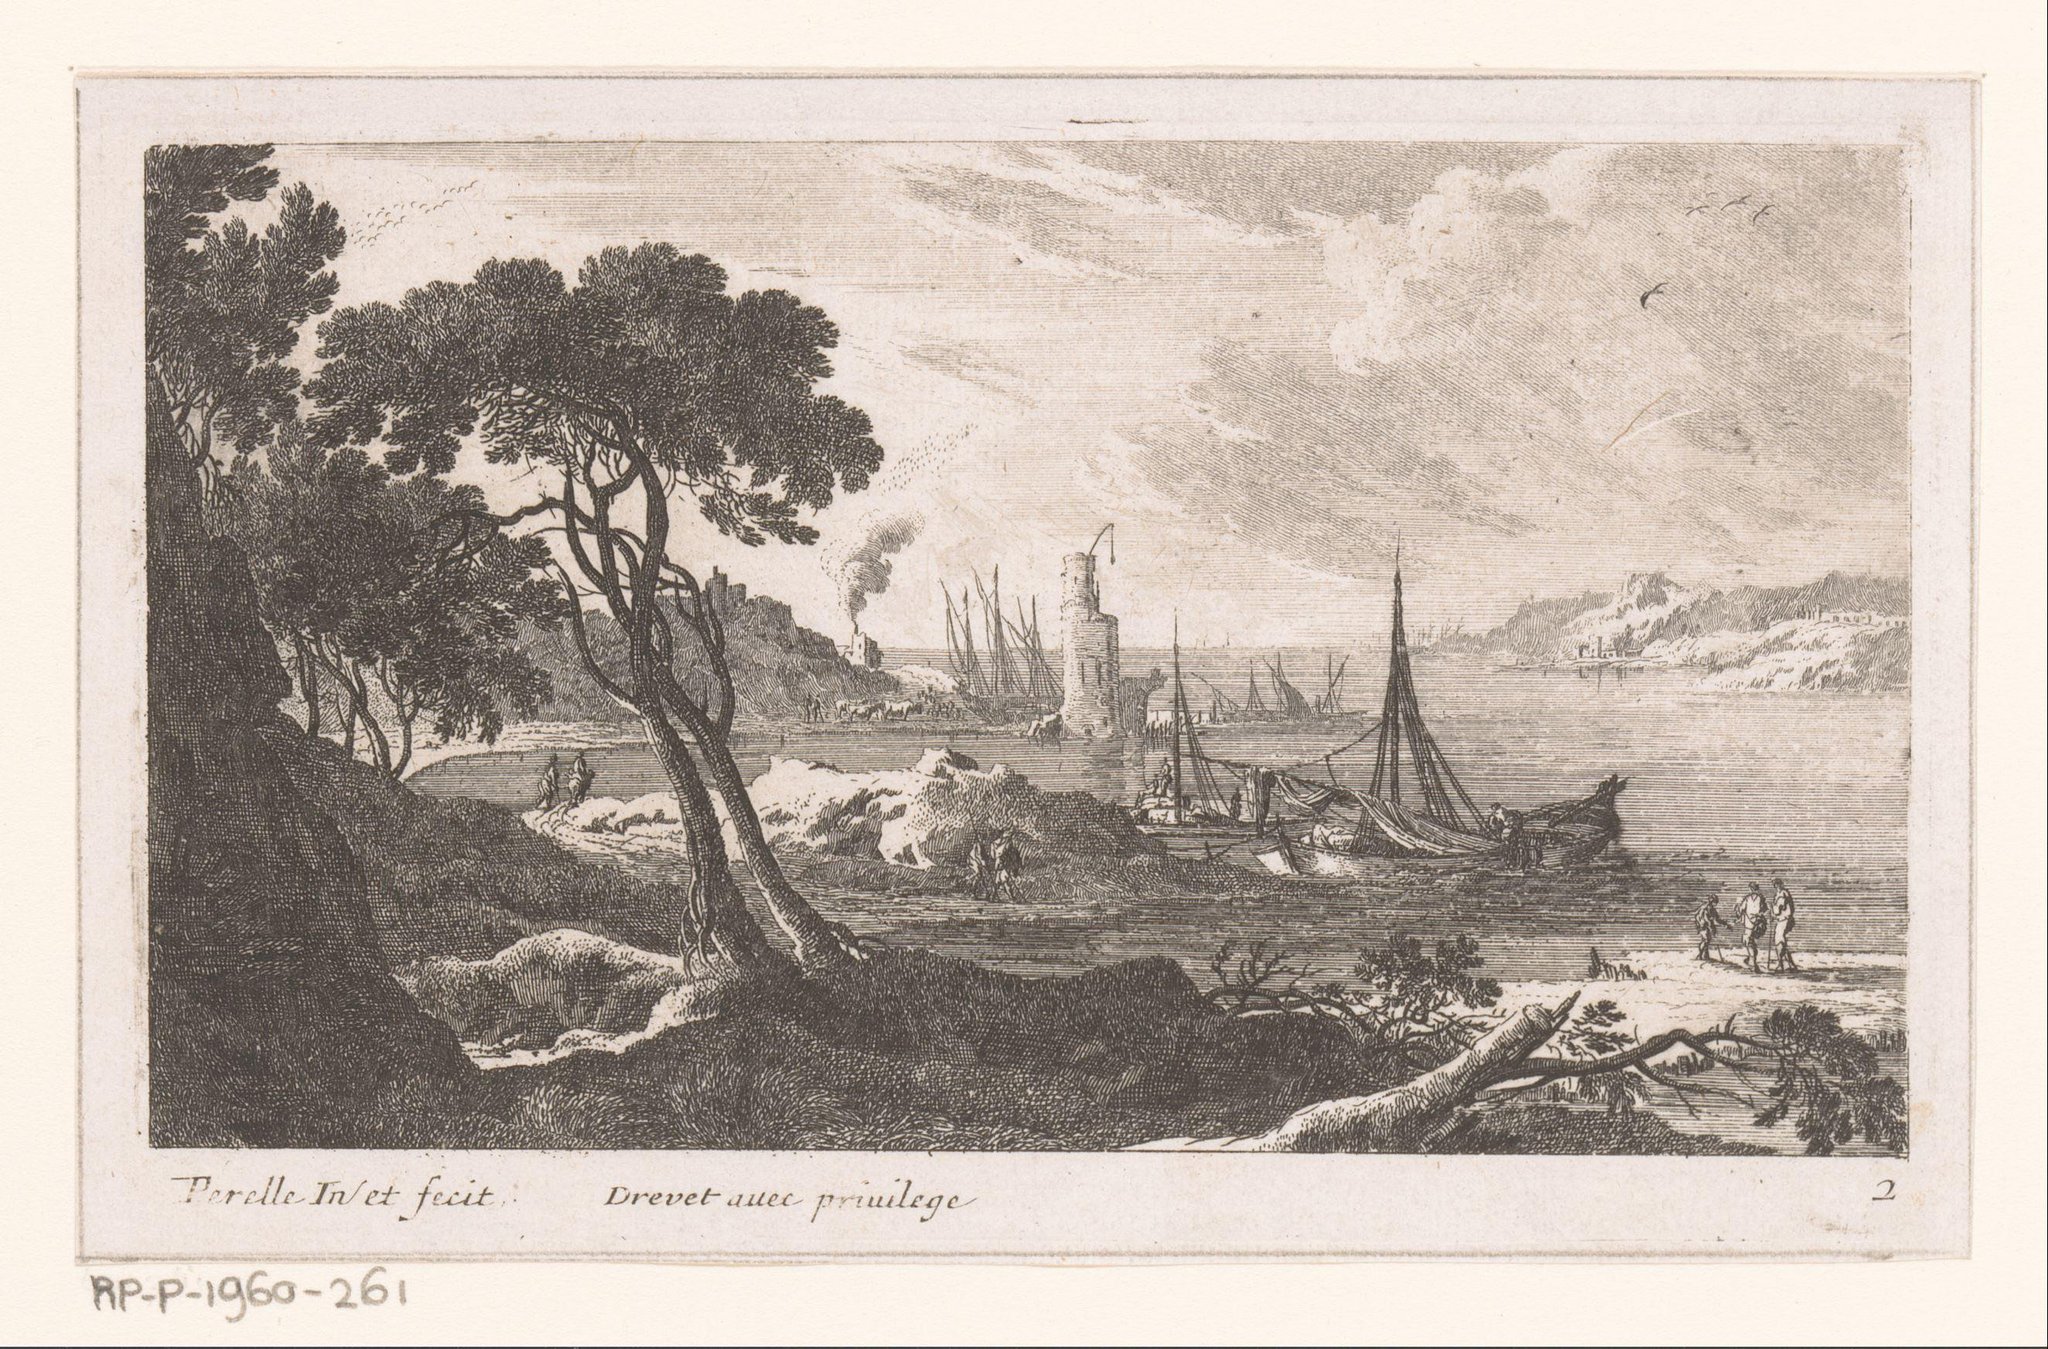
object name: print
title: Kustlandschap met vuurtoren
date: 1673-1695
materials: paper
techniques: etching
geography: france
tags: lighthouse, lightship, coast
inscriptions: collector's mark: Lugt 2228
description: Prenten met het signatuur 'Perelle' kunnen zowel door vader Gabriel als door zonen Nicolas en Adam gemaakt zijn.